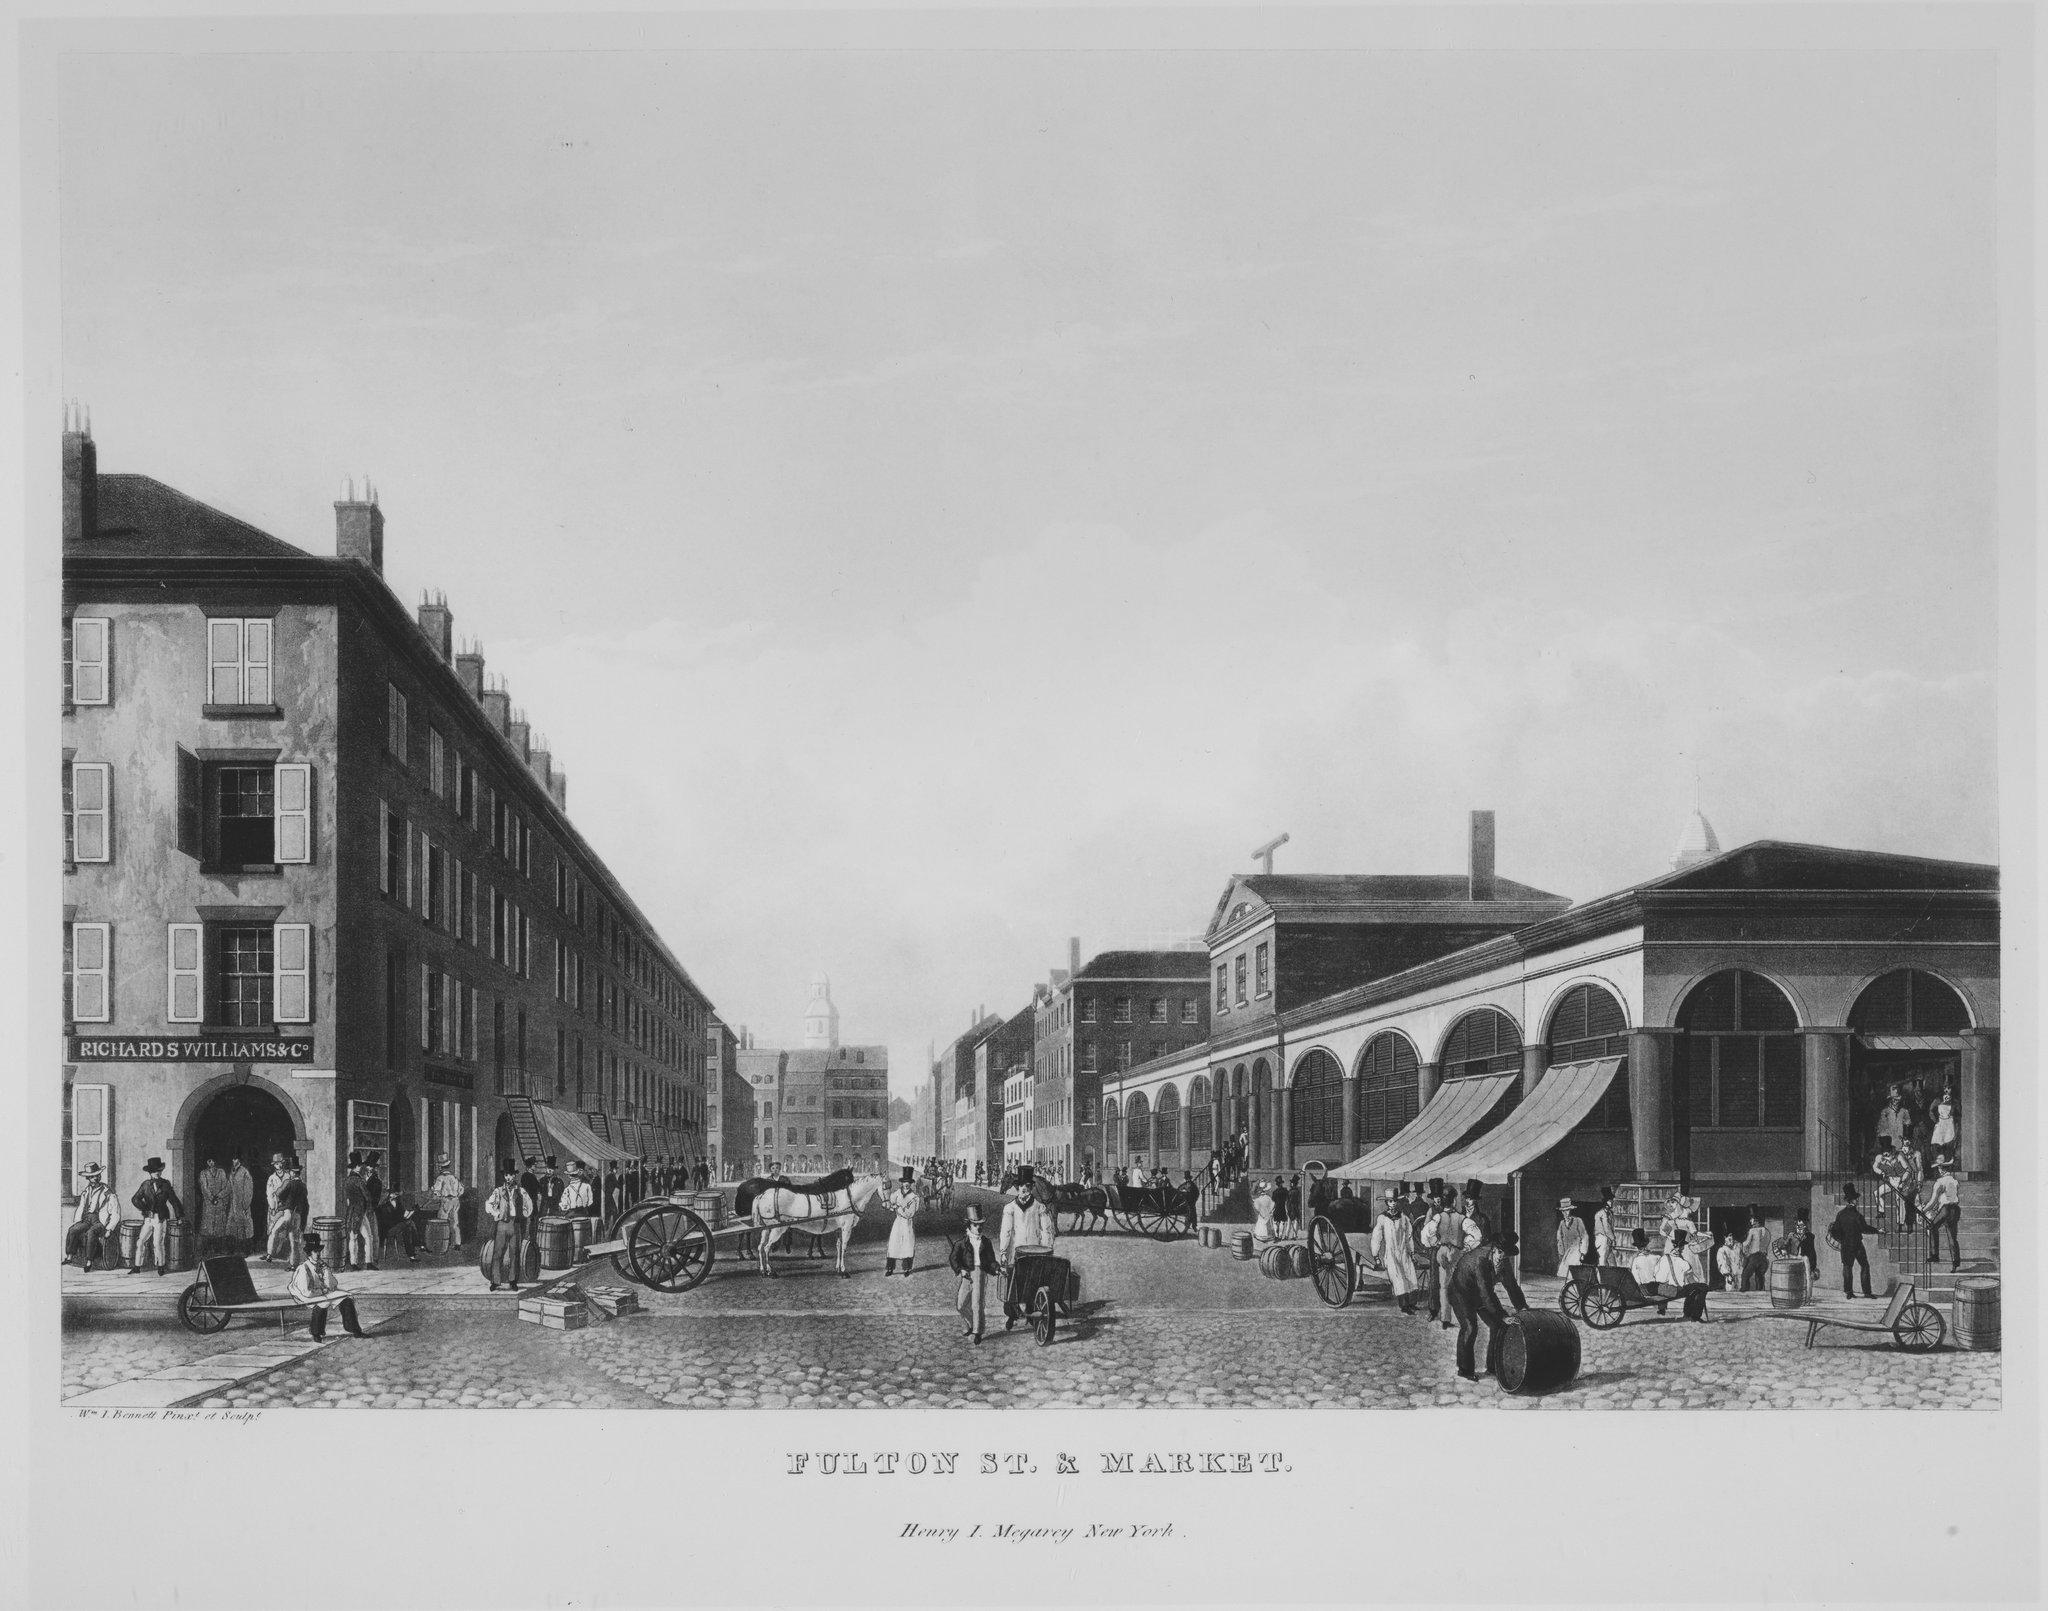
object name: print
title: Fulton Street & Market, New York (The Bennett View of Fulton Street)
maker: william james bennett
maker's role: artist and engraver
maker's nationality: american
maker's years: 1787-1844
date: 1834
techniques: aquatint, hand coloring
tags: buildings,streets,horses,markets,new york city